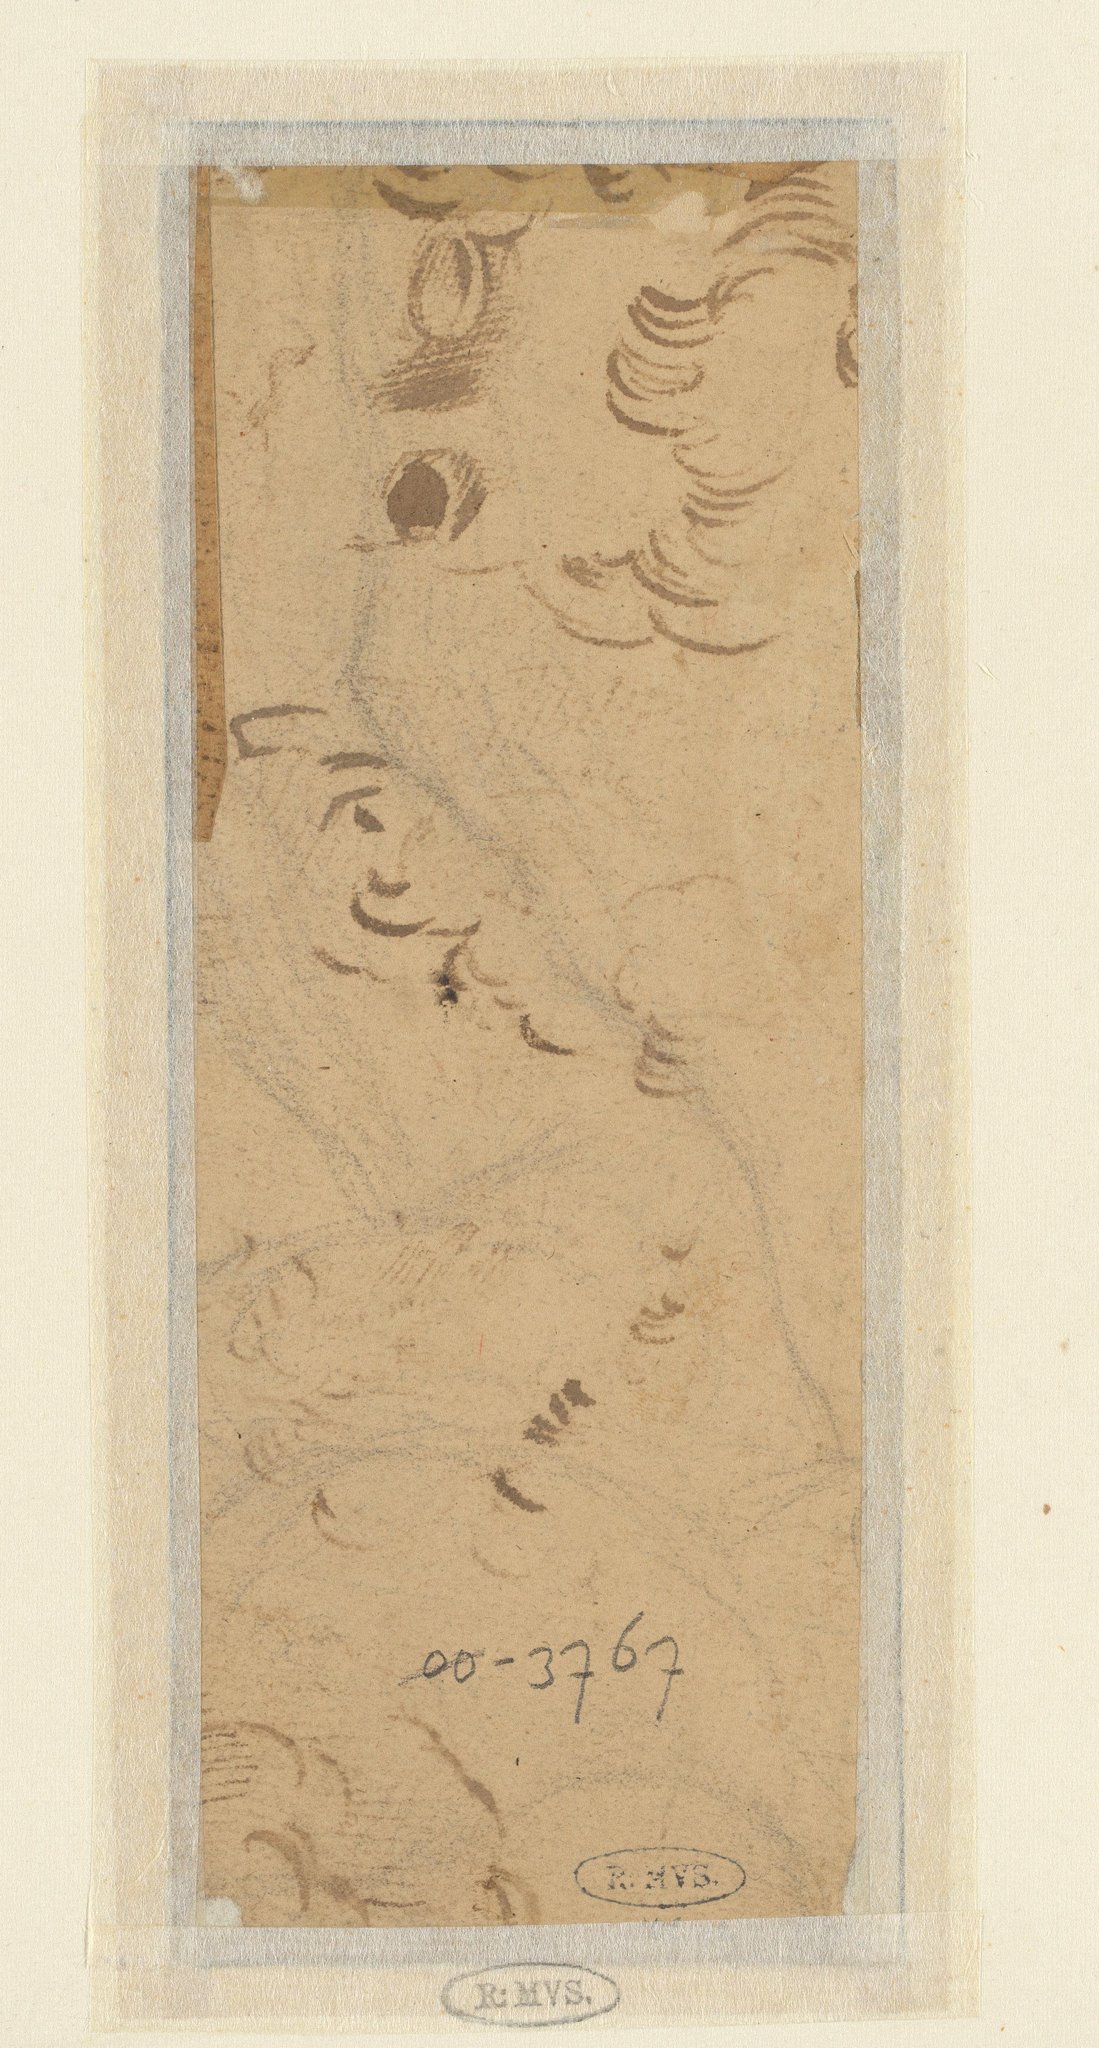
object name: drawing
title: Kop en een mannelijke borst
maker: raffaele da montelupo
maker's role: draughtsman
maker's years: 1505-1567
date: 1515-1566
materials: chalk, ink, paper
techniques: pen